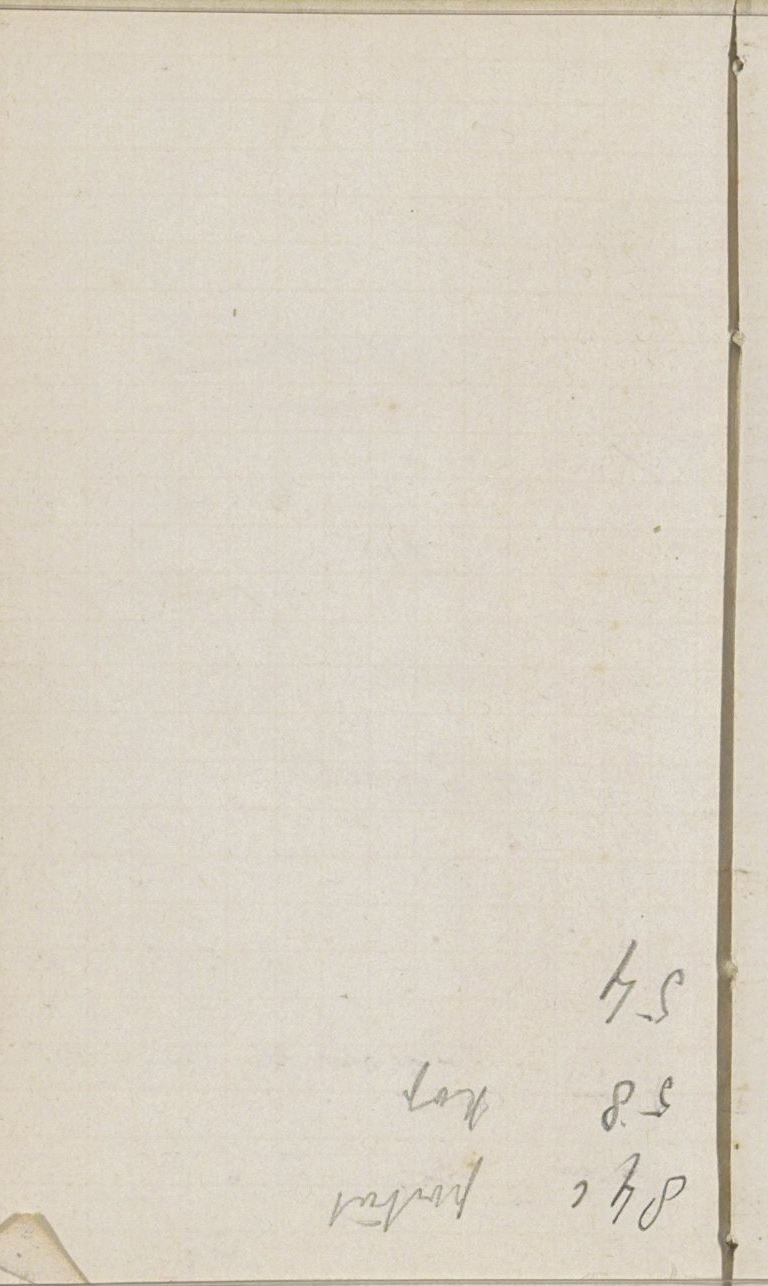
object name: sketchbook leaf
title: Notities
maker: jan willem van borselen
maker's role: draughtsman, print maker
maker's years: 1825-1892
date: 1868-1887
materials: pencil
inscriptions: annotation: ‘84c portat/ 58 kop/ [...]’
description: Blad 50 verso uit een schetsboek met 51 bladen.